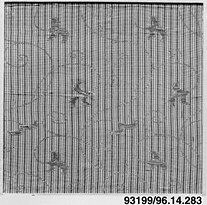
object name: piece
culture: japanese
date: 1701-1900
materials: silk